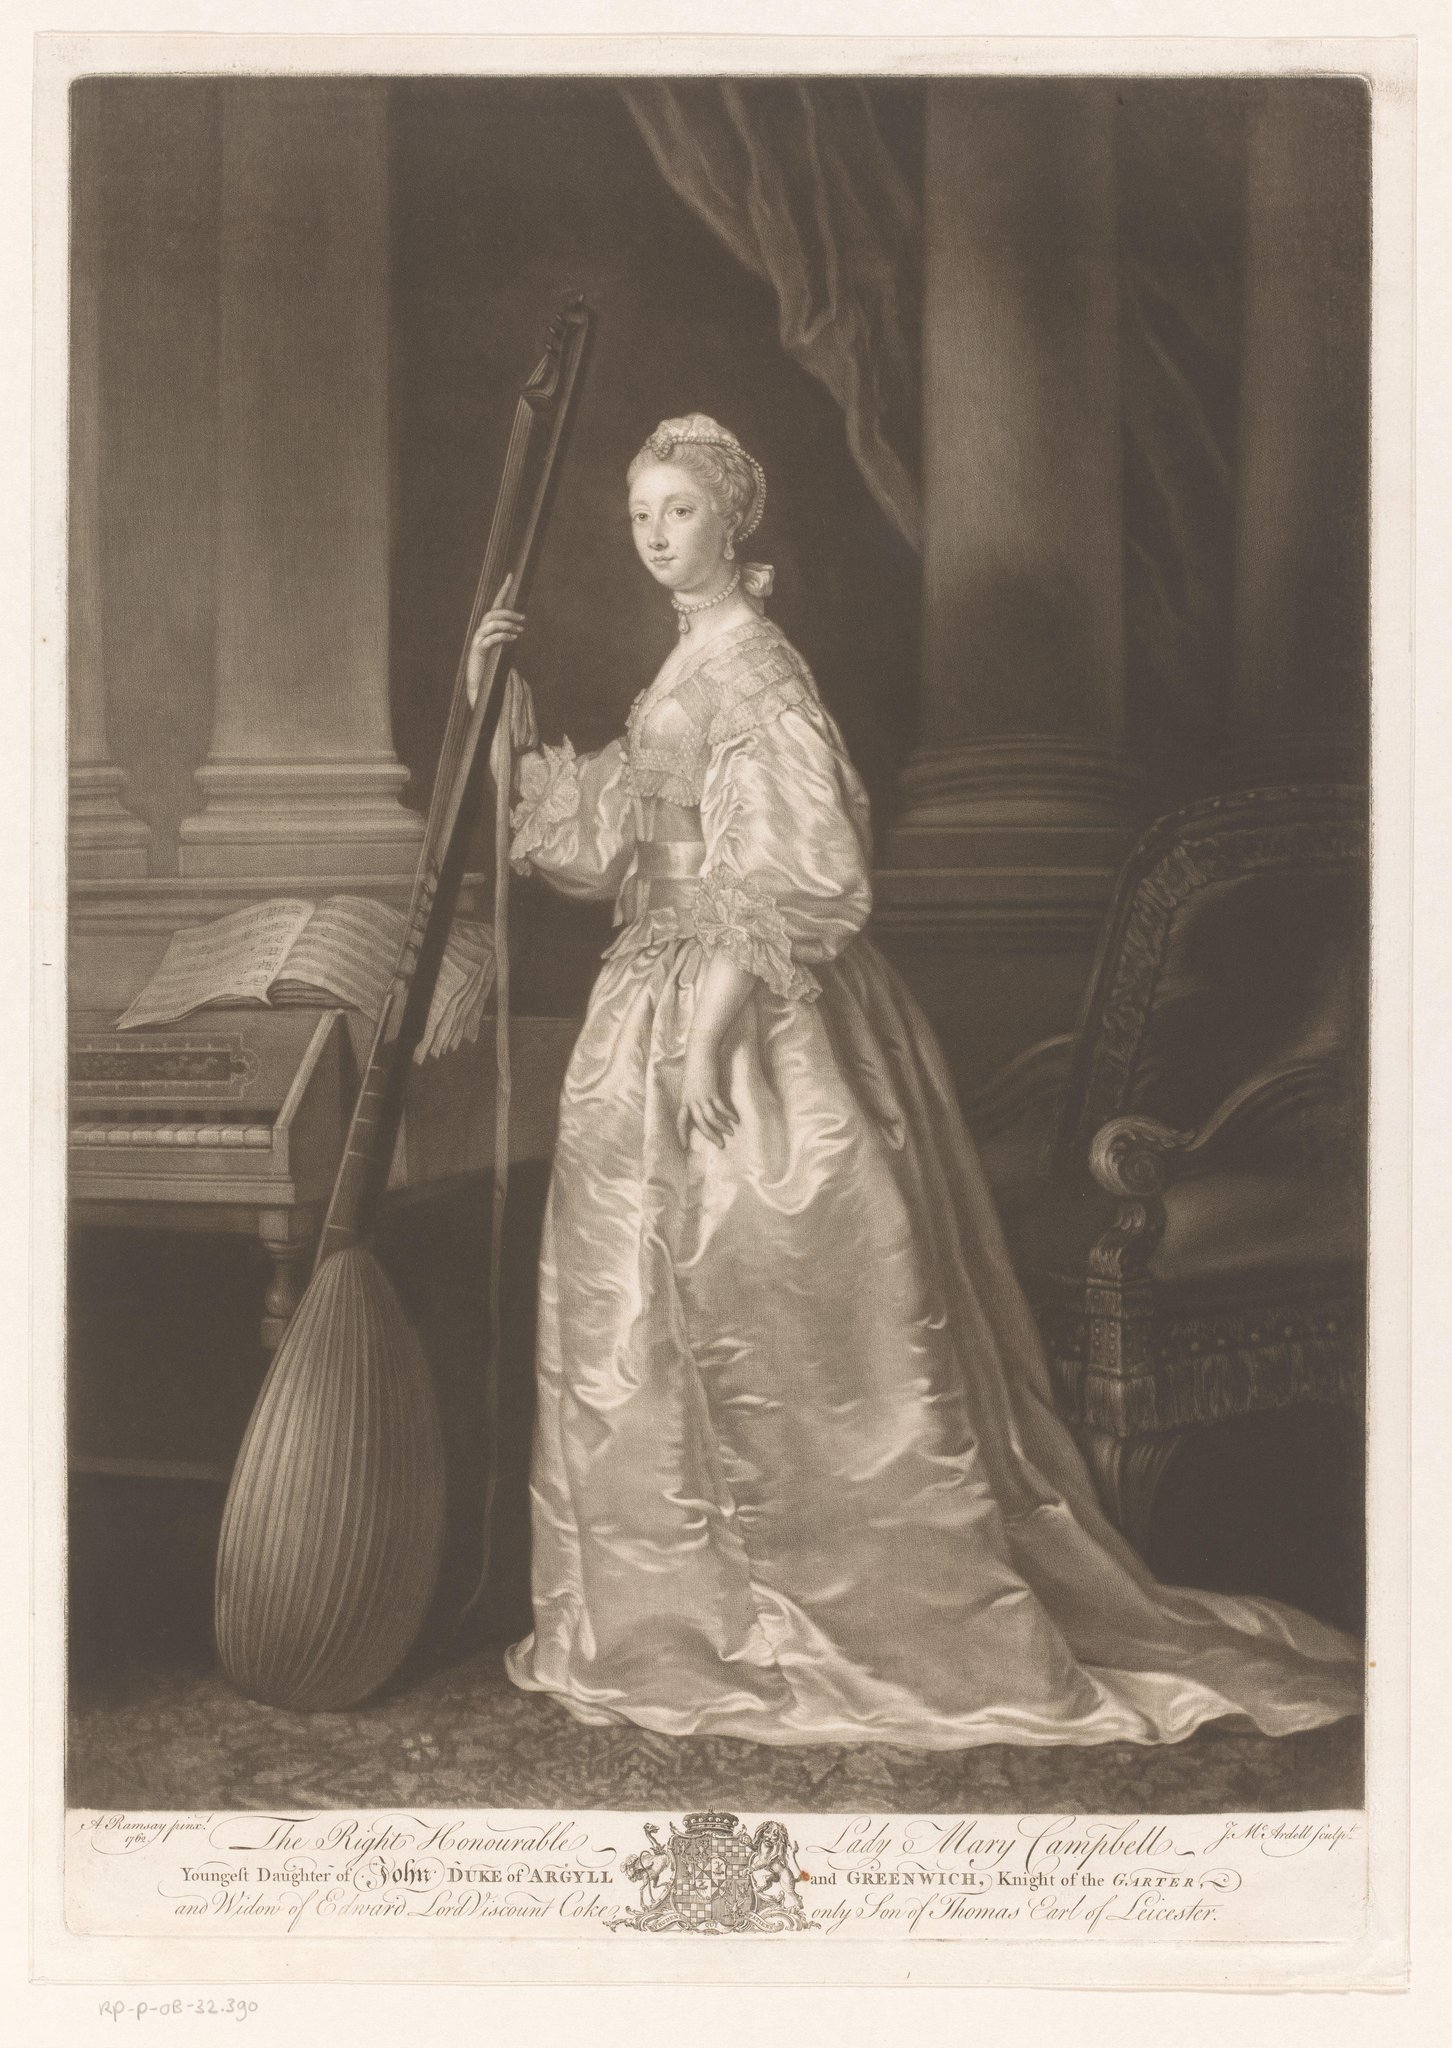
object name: print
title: Portret van Mary Coke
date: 1762-1764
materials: paper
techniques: mezzotint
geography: london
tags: historical persons - bb - woman, lute, and special forms of lute, e.g.: theorbo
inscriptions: collector's mark: Lugt 240